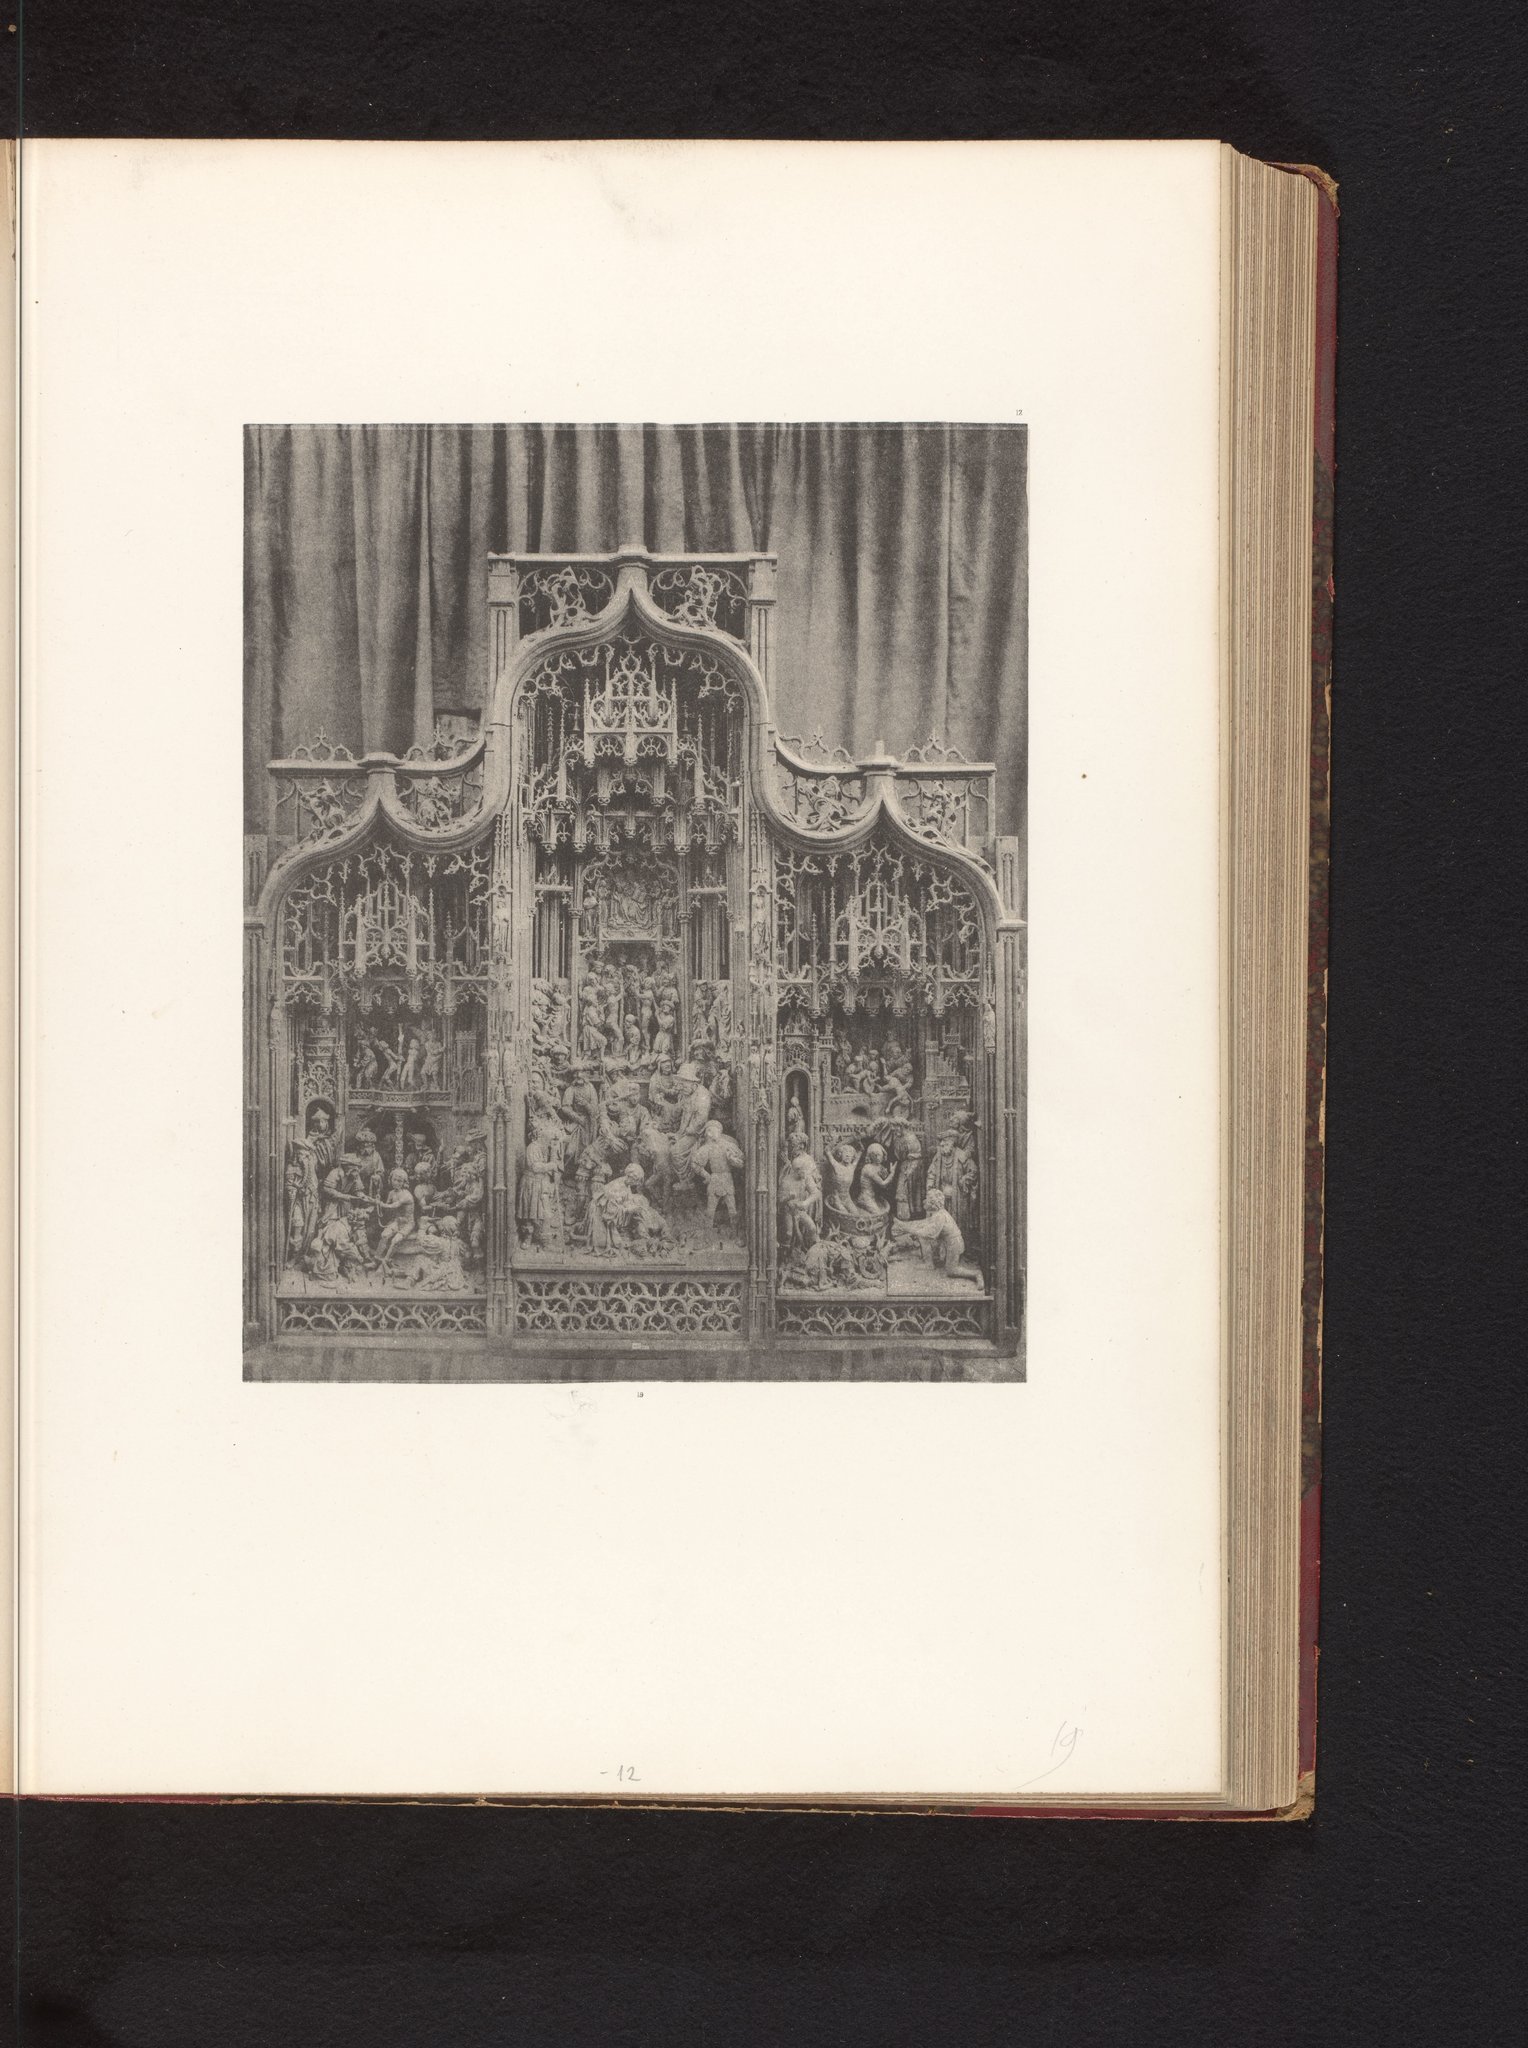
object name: page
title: Eikenhouten altaarstuk uit de Sint-Waltrudiskerk in Herentals, opgesteld op een tentoonstelling over religieuze objecten uit de middeleeuwen en renaissance in 1864 in Mechelen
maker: joseph maes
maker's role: fotograaf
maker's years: 1838-1908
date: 1864-1866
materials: paper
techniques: photolithography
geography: antwerp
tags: piece of sculpture, reproduction of a piece of sculpture (+ wood, e.g.: panel ~ arts), altar with altar-piece, mechelen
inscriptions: number: ‘19’, number: ‘-12’, number: ‘19’